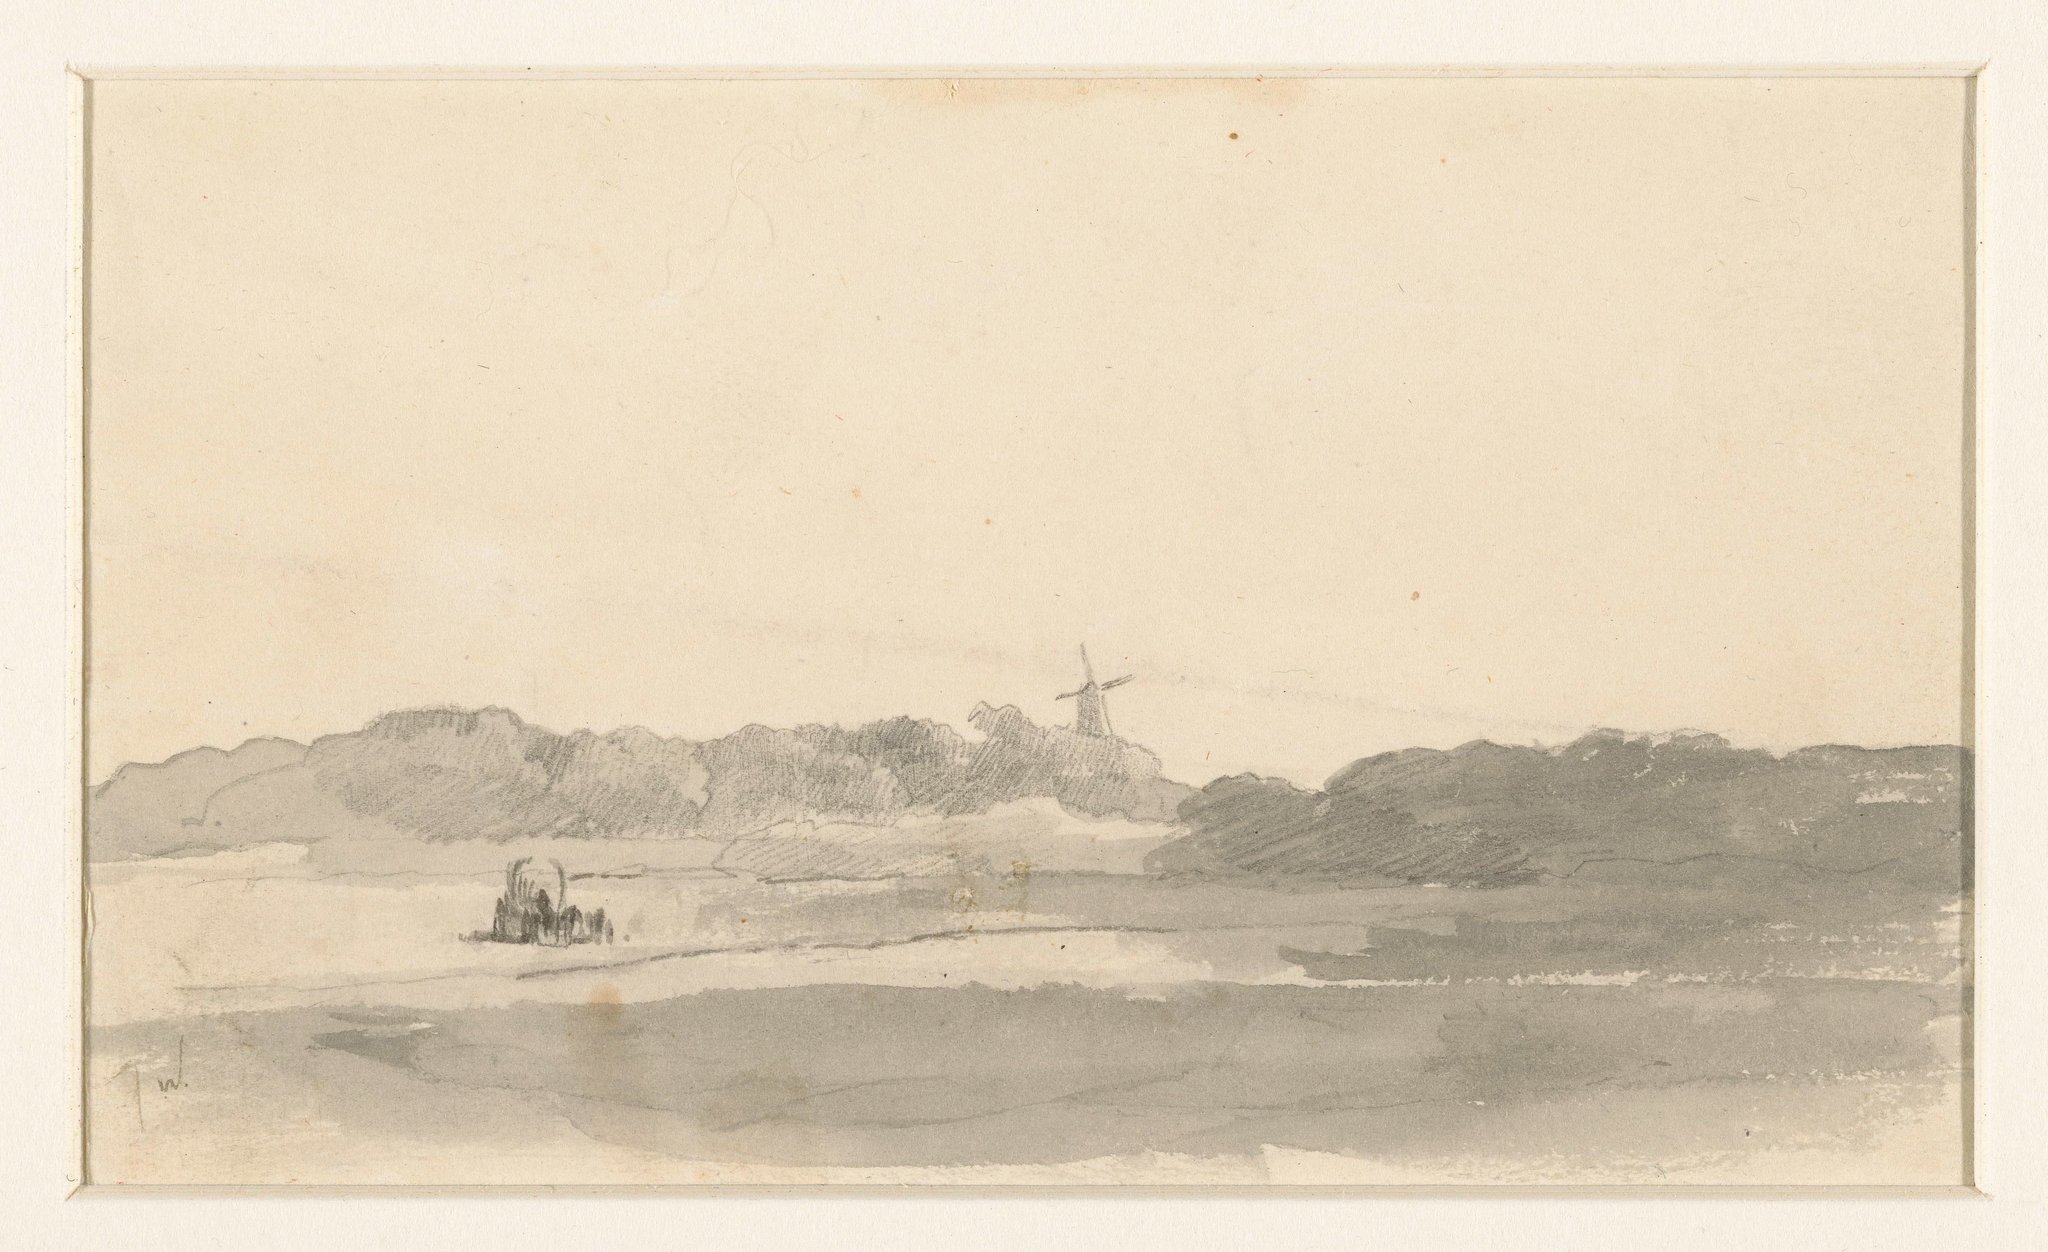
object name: drawing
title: Weidelandschap met hooiwagen en windmolen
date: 1800-1900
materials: paper, pencil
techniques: brush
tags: meadow, pasture, windmill in landscape